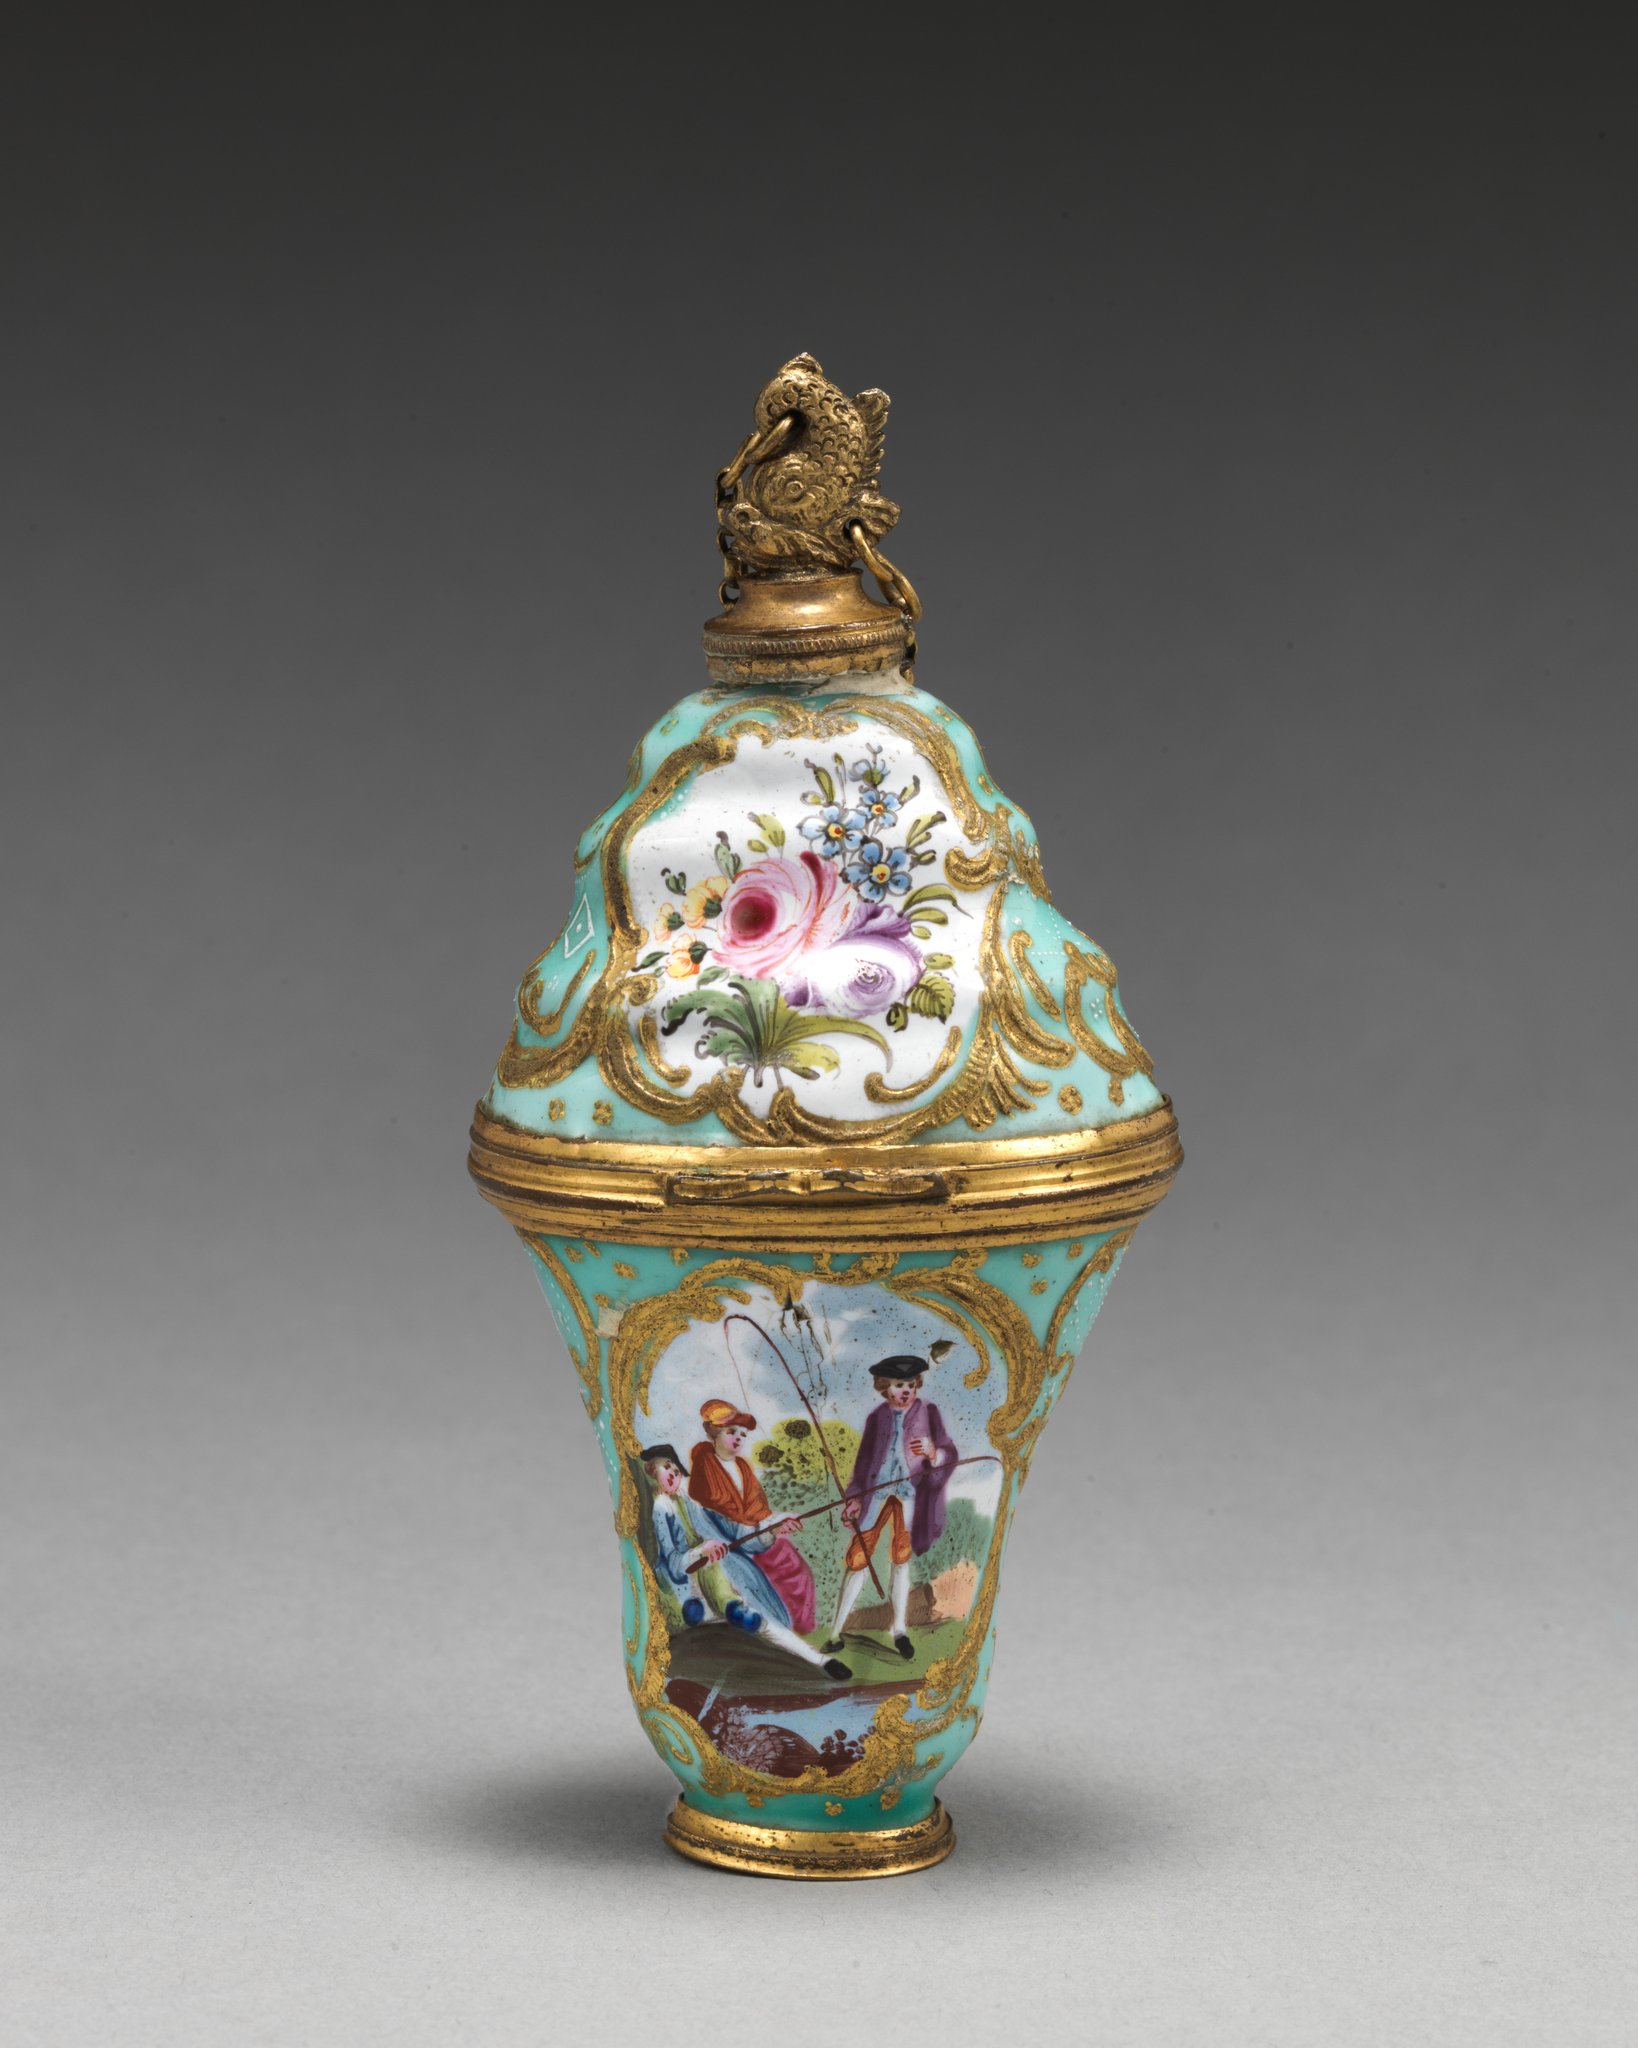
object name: scent bottle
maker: robert sayer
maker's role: publisher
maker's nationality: british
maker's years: 1725-1794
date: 1765-1770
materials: copper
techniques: enamel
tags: men,women,flowers